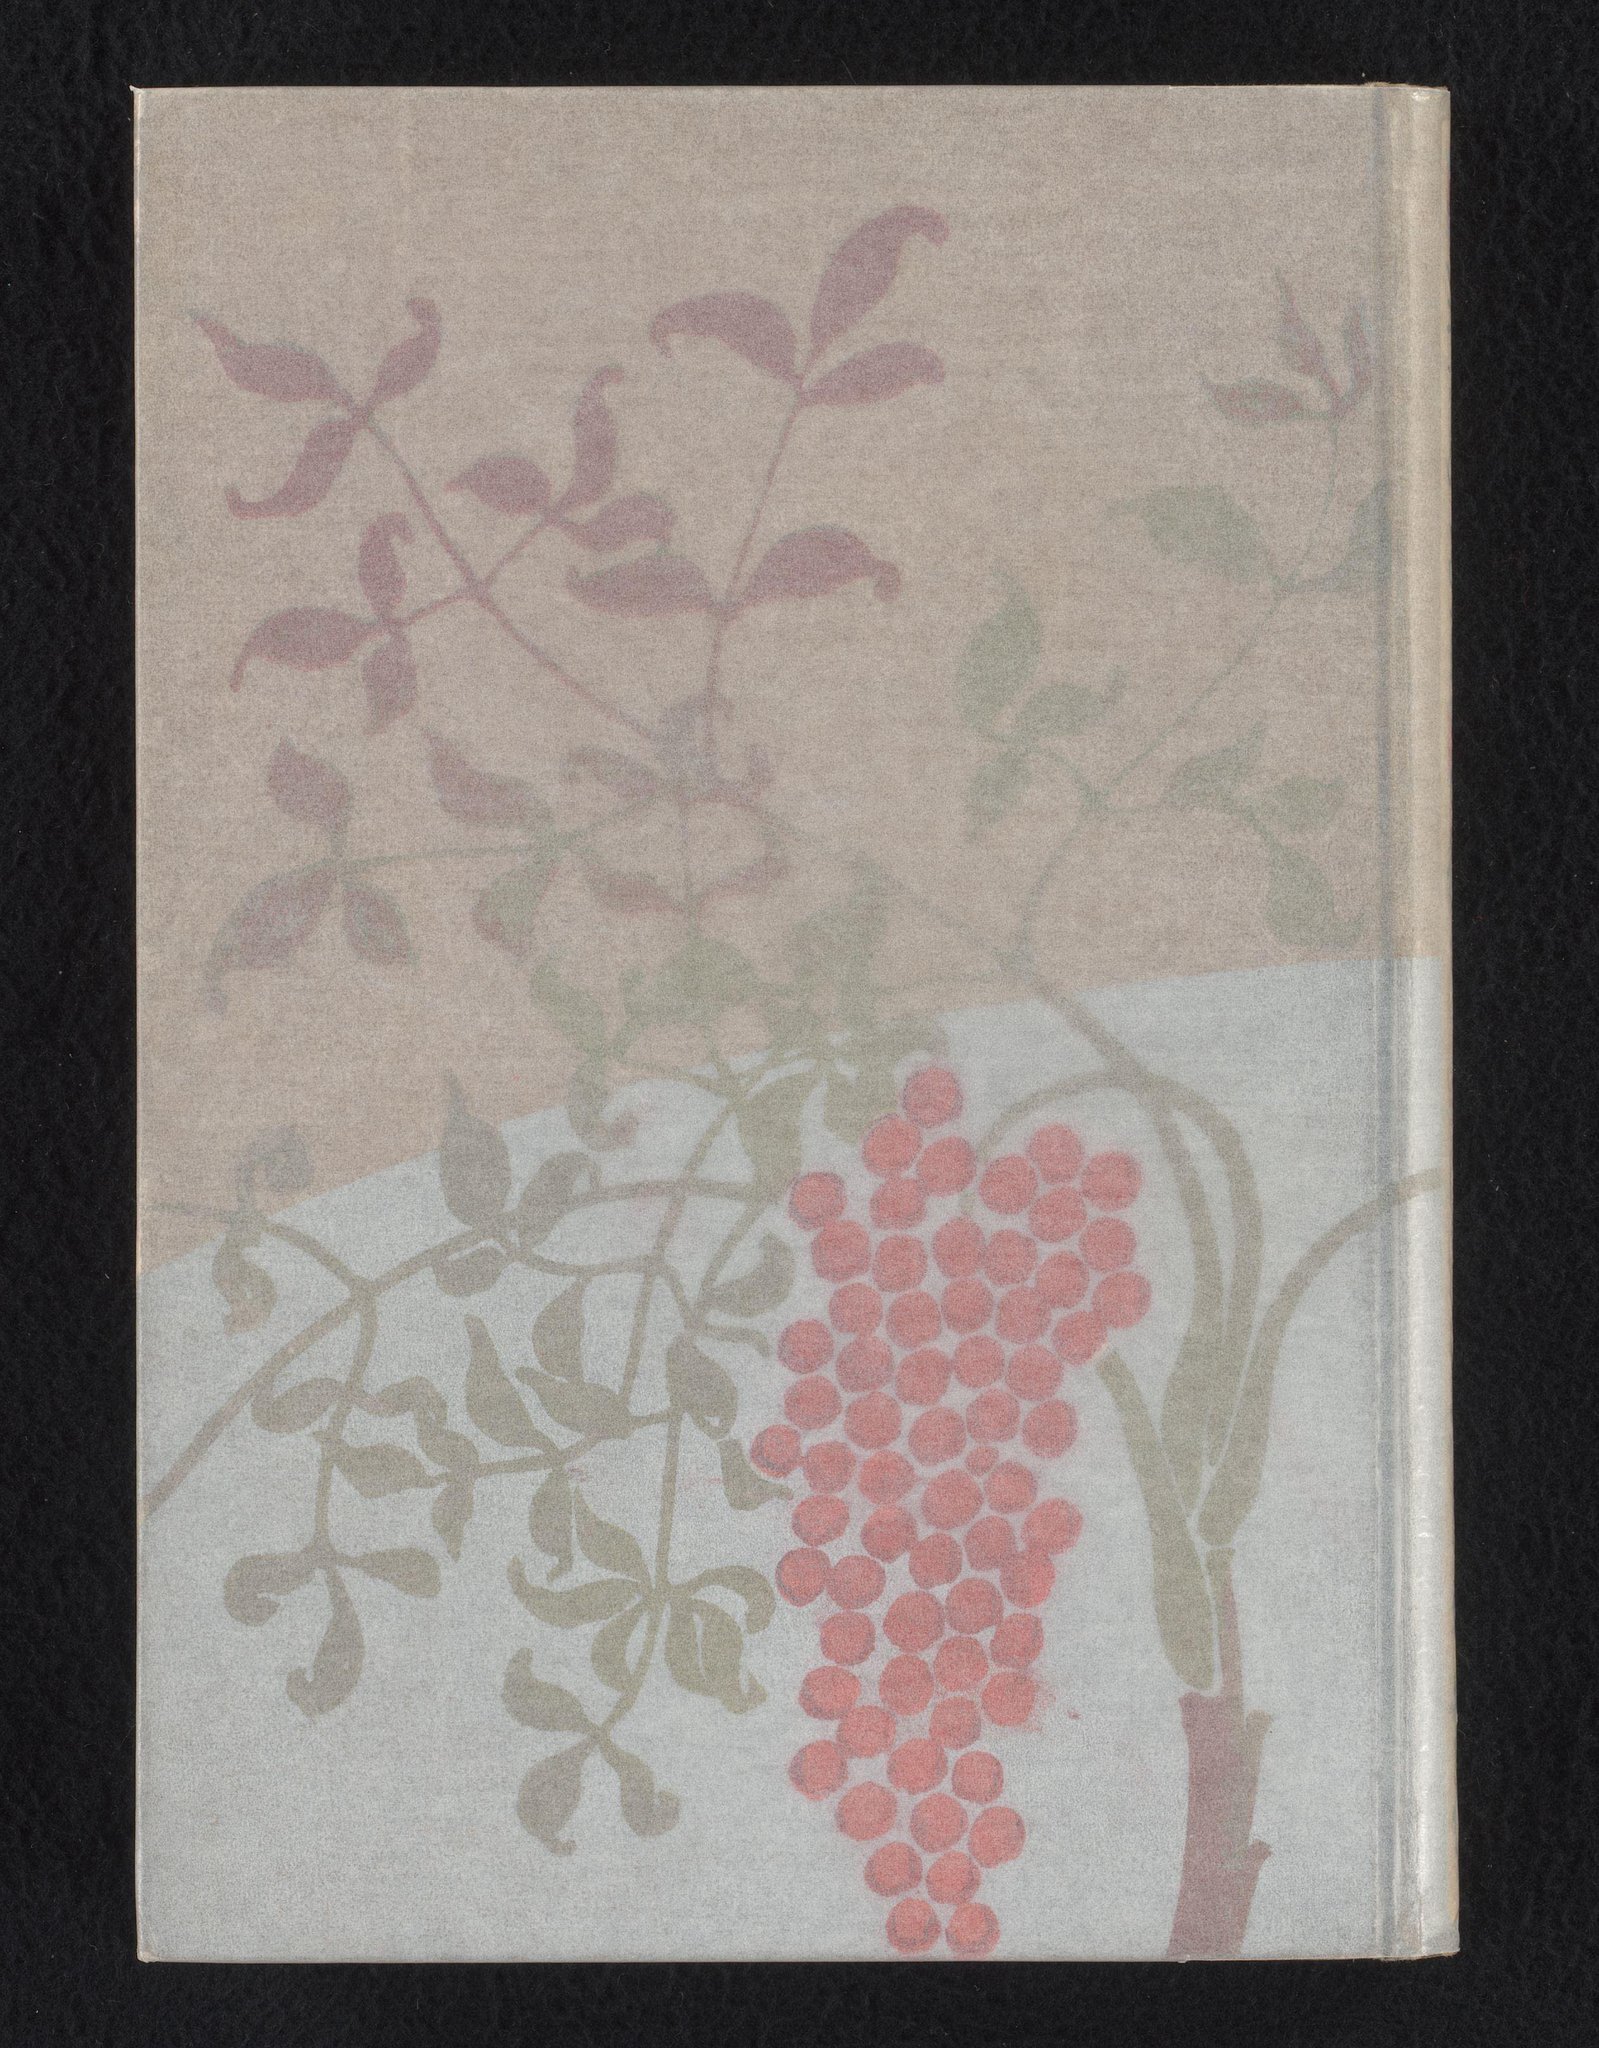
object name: book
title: Nasanunaka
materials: paper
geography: japan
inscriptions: date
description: The sequel from a novel complete in three volumes and a sequel. Slipcase, book cover and endpapers are designed by Sugiura Hisui; Two frontispiece colour woodcuts by Eiho.